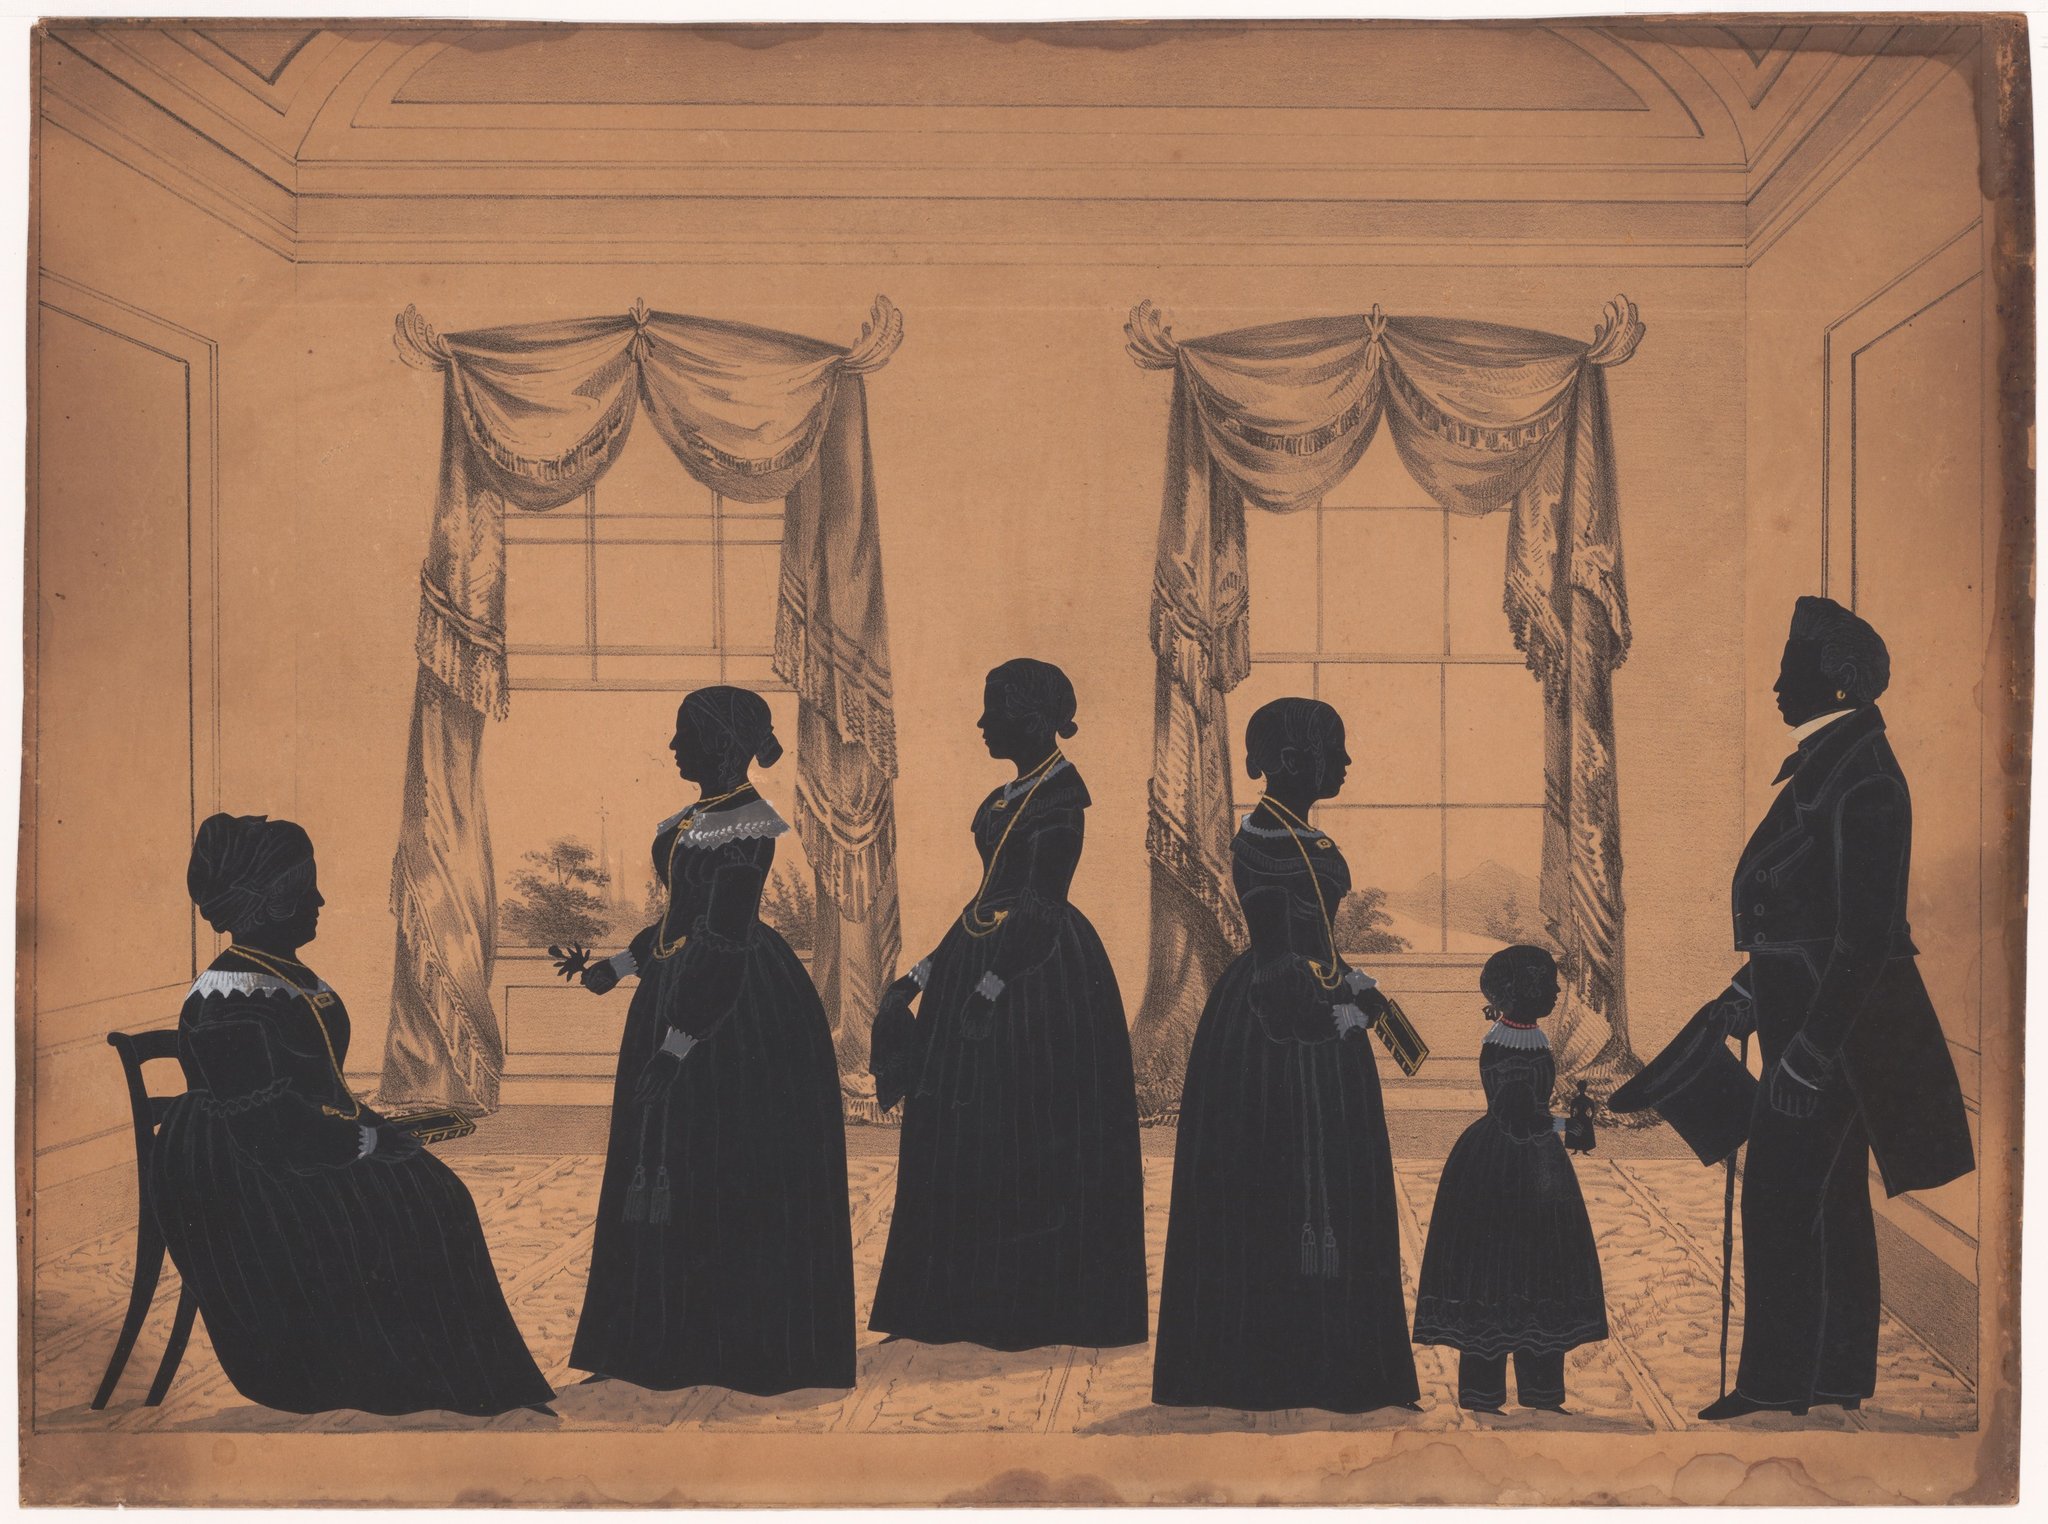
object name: cut paper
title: Thomas Williams, the Town Crier of New Bedford with Wife and Daughter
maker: samuel metford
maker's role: artist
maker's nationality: british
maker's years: 1810-1896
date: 1801-1900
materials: gold, paper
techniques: cutting, lithograph, wash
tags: girls,men,women